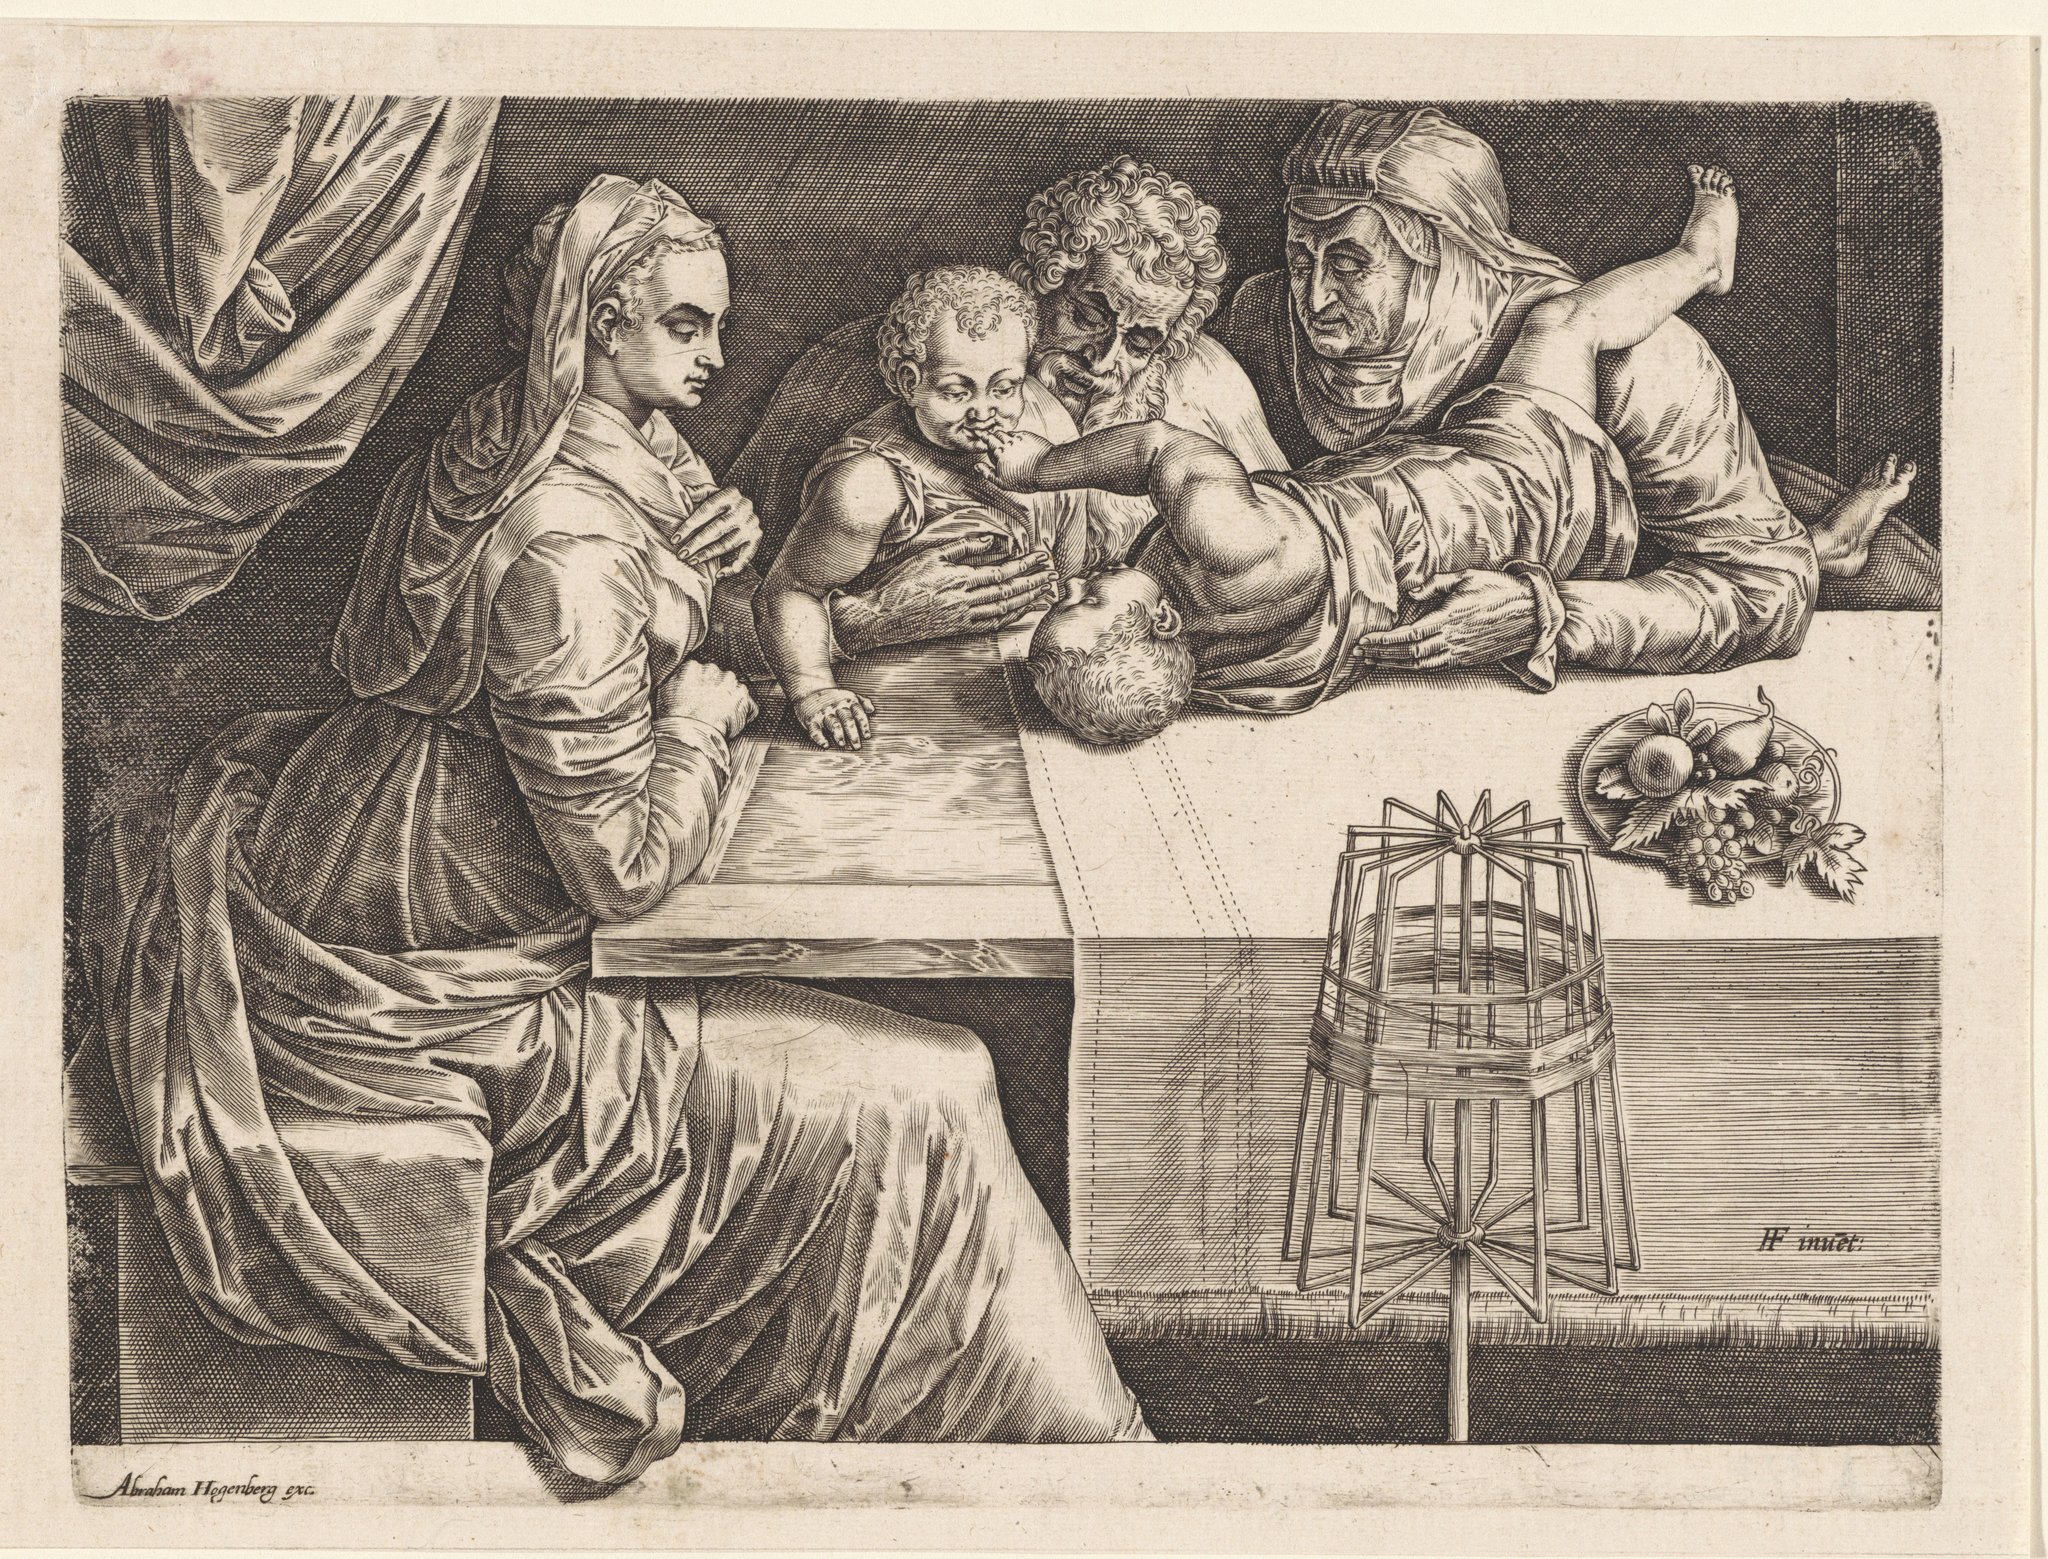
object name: print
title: Heilige Familie met Elisabet en Johannes de Doper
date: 1550-1578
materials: paper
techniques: engraving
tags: spindle, holy family with john the baptist, elisabeth present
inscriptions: collector's mark: Lugt 2228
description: Maria, Jozef en Elisabet zitten aan tafel in een vertrek. Jozef heeft het Christuskind op schoot. Johannes de Doper ligt op de tafel en steekt zijn vinger in de mond van Christus. Op de voorgrond een spintol.